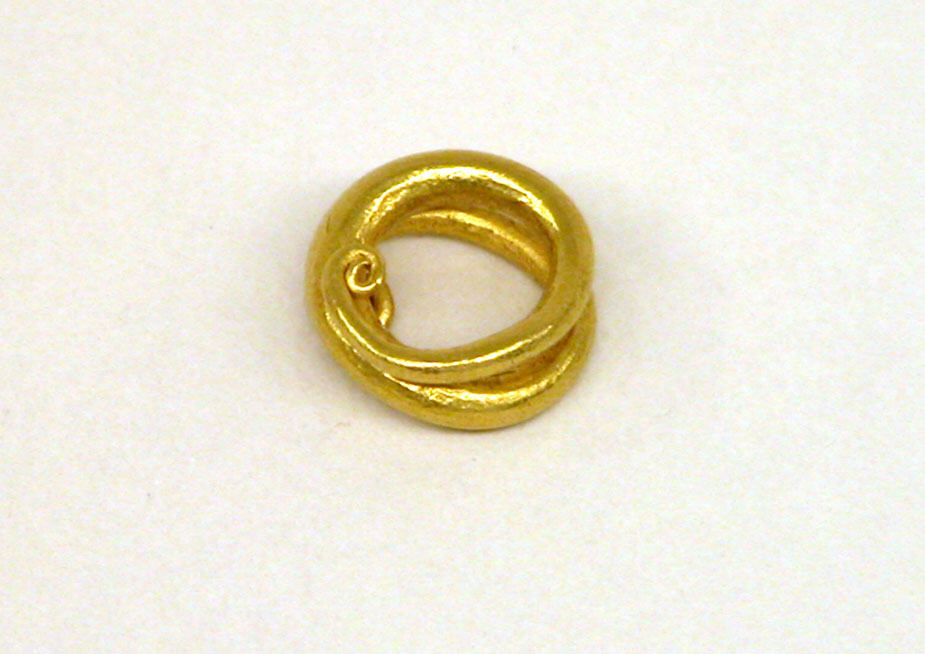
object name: ear ornament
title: Pair of Ear Ornaments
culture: indonesian, javanese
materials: gold